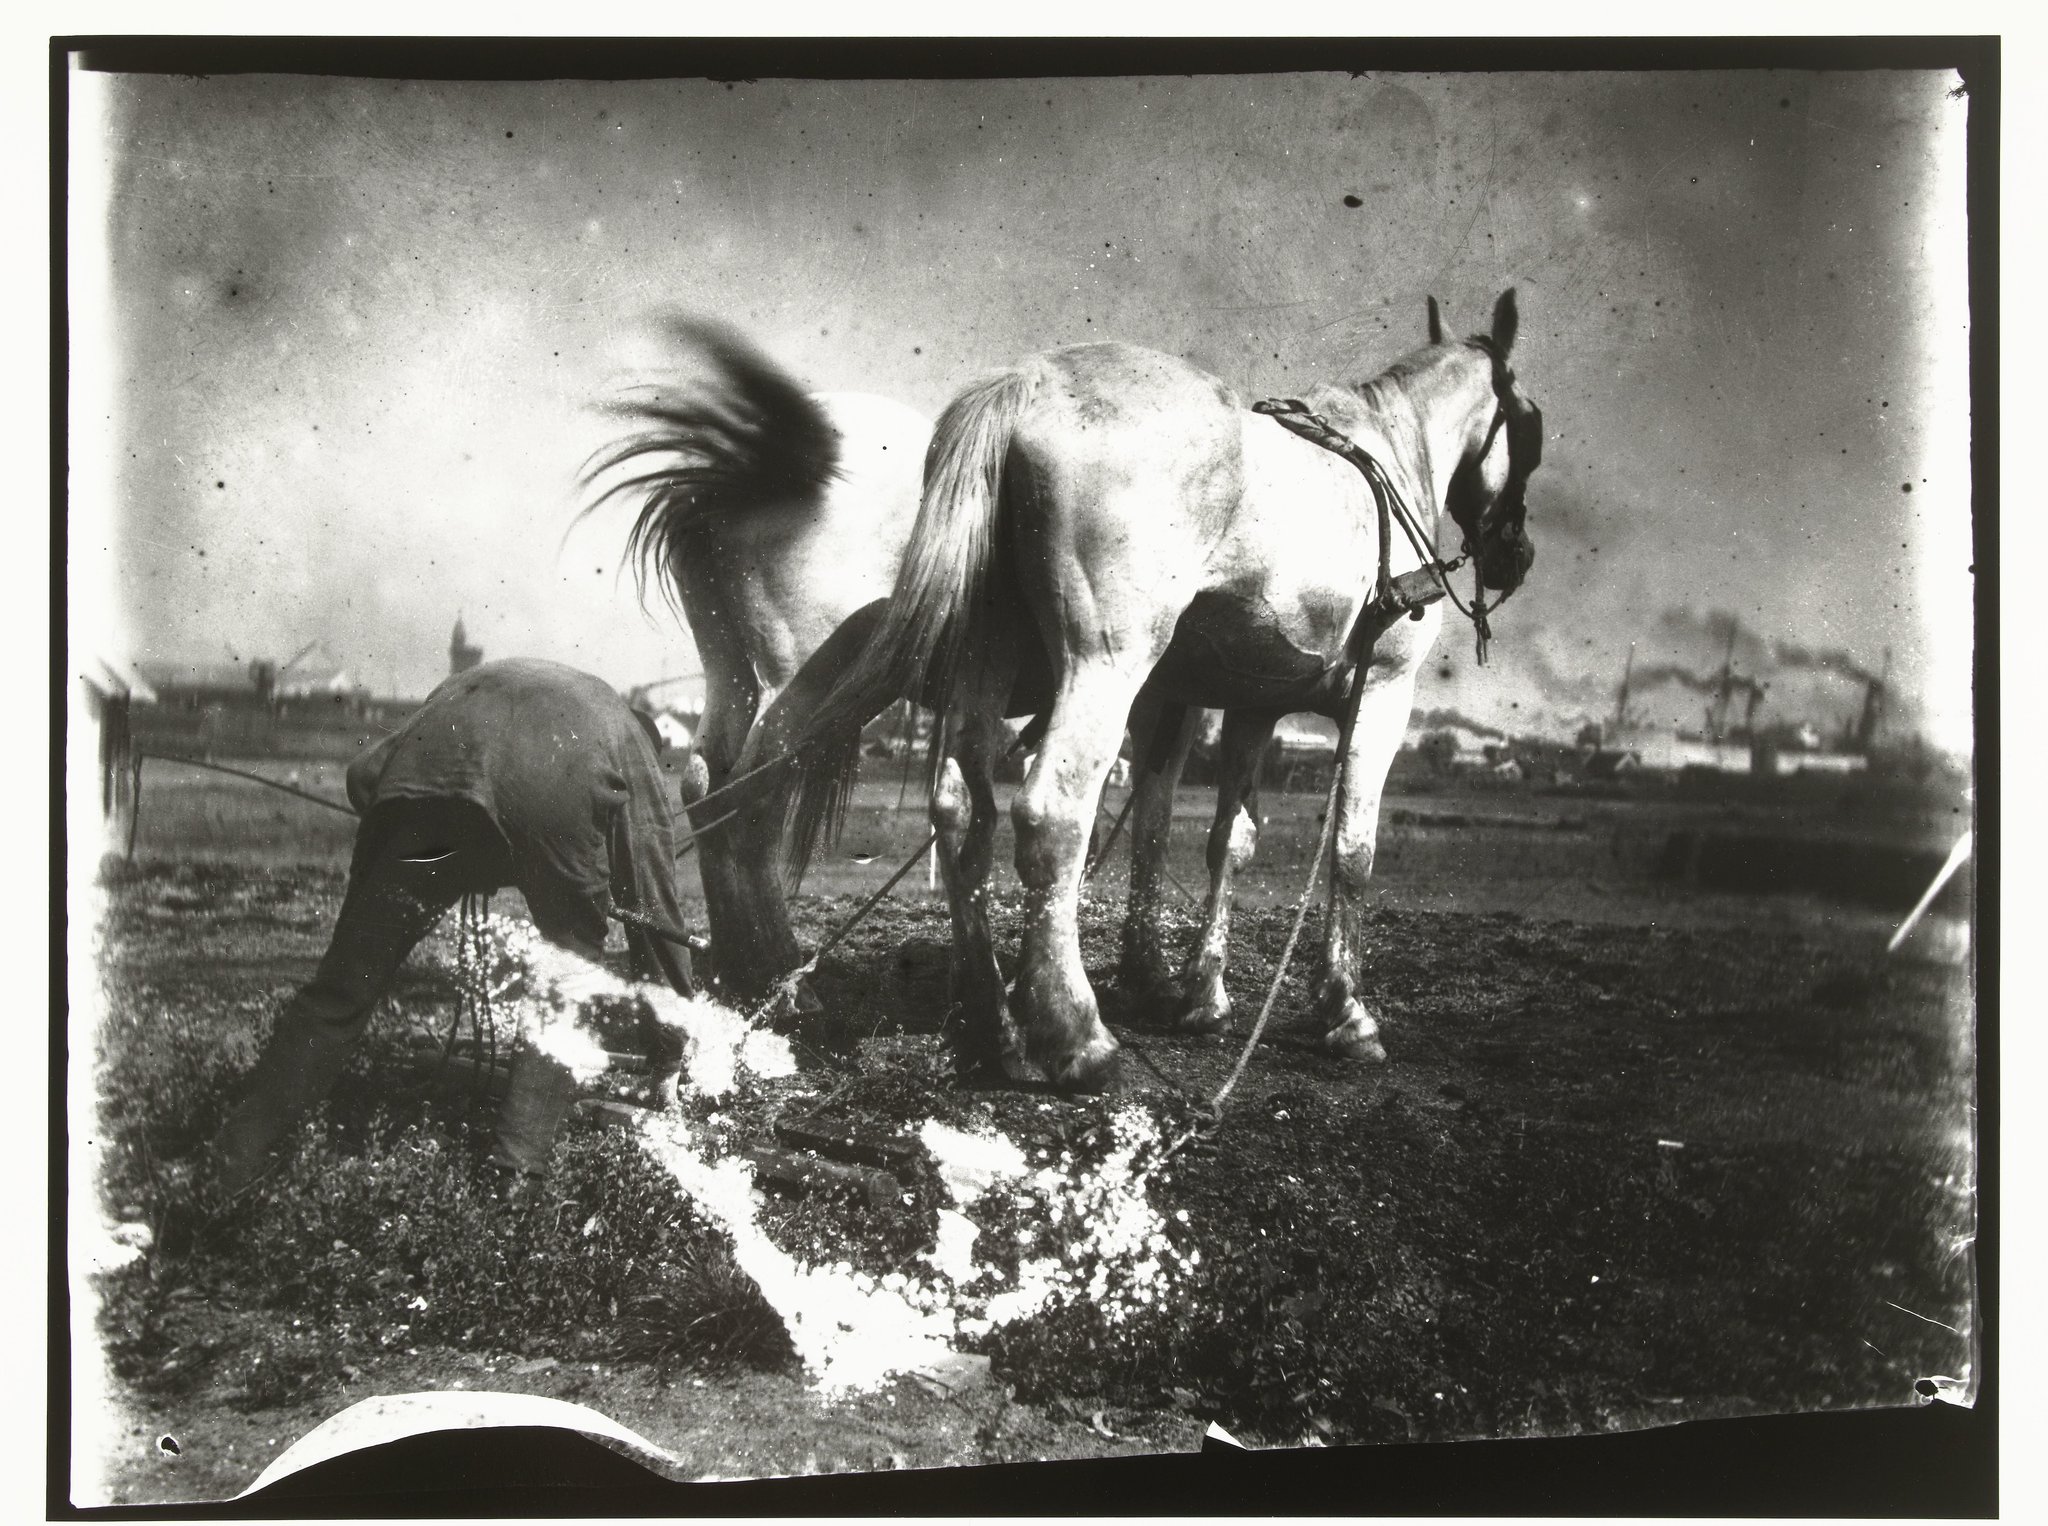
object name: photograph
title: Het ploegen van een veld door paarden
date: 1890-1910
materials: paper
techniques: gelatin silver print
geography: netherlands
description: Moderne afdruk van negatief BR 1845 (collectie RKD).